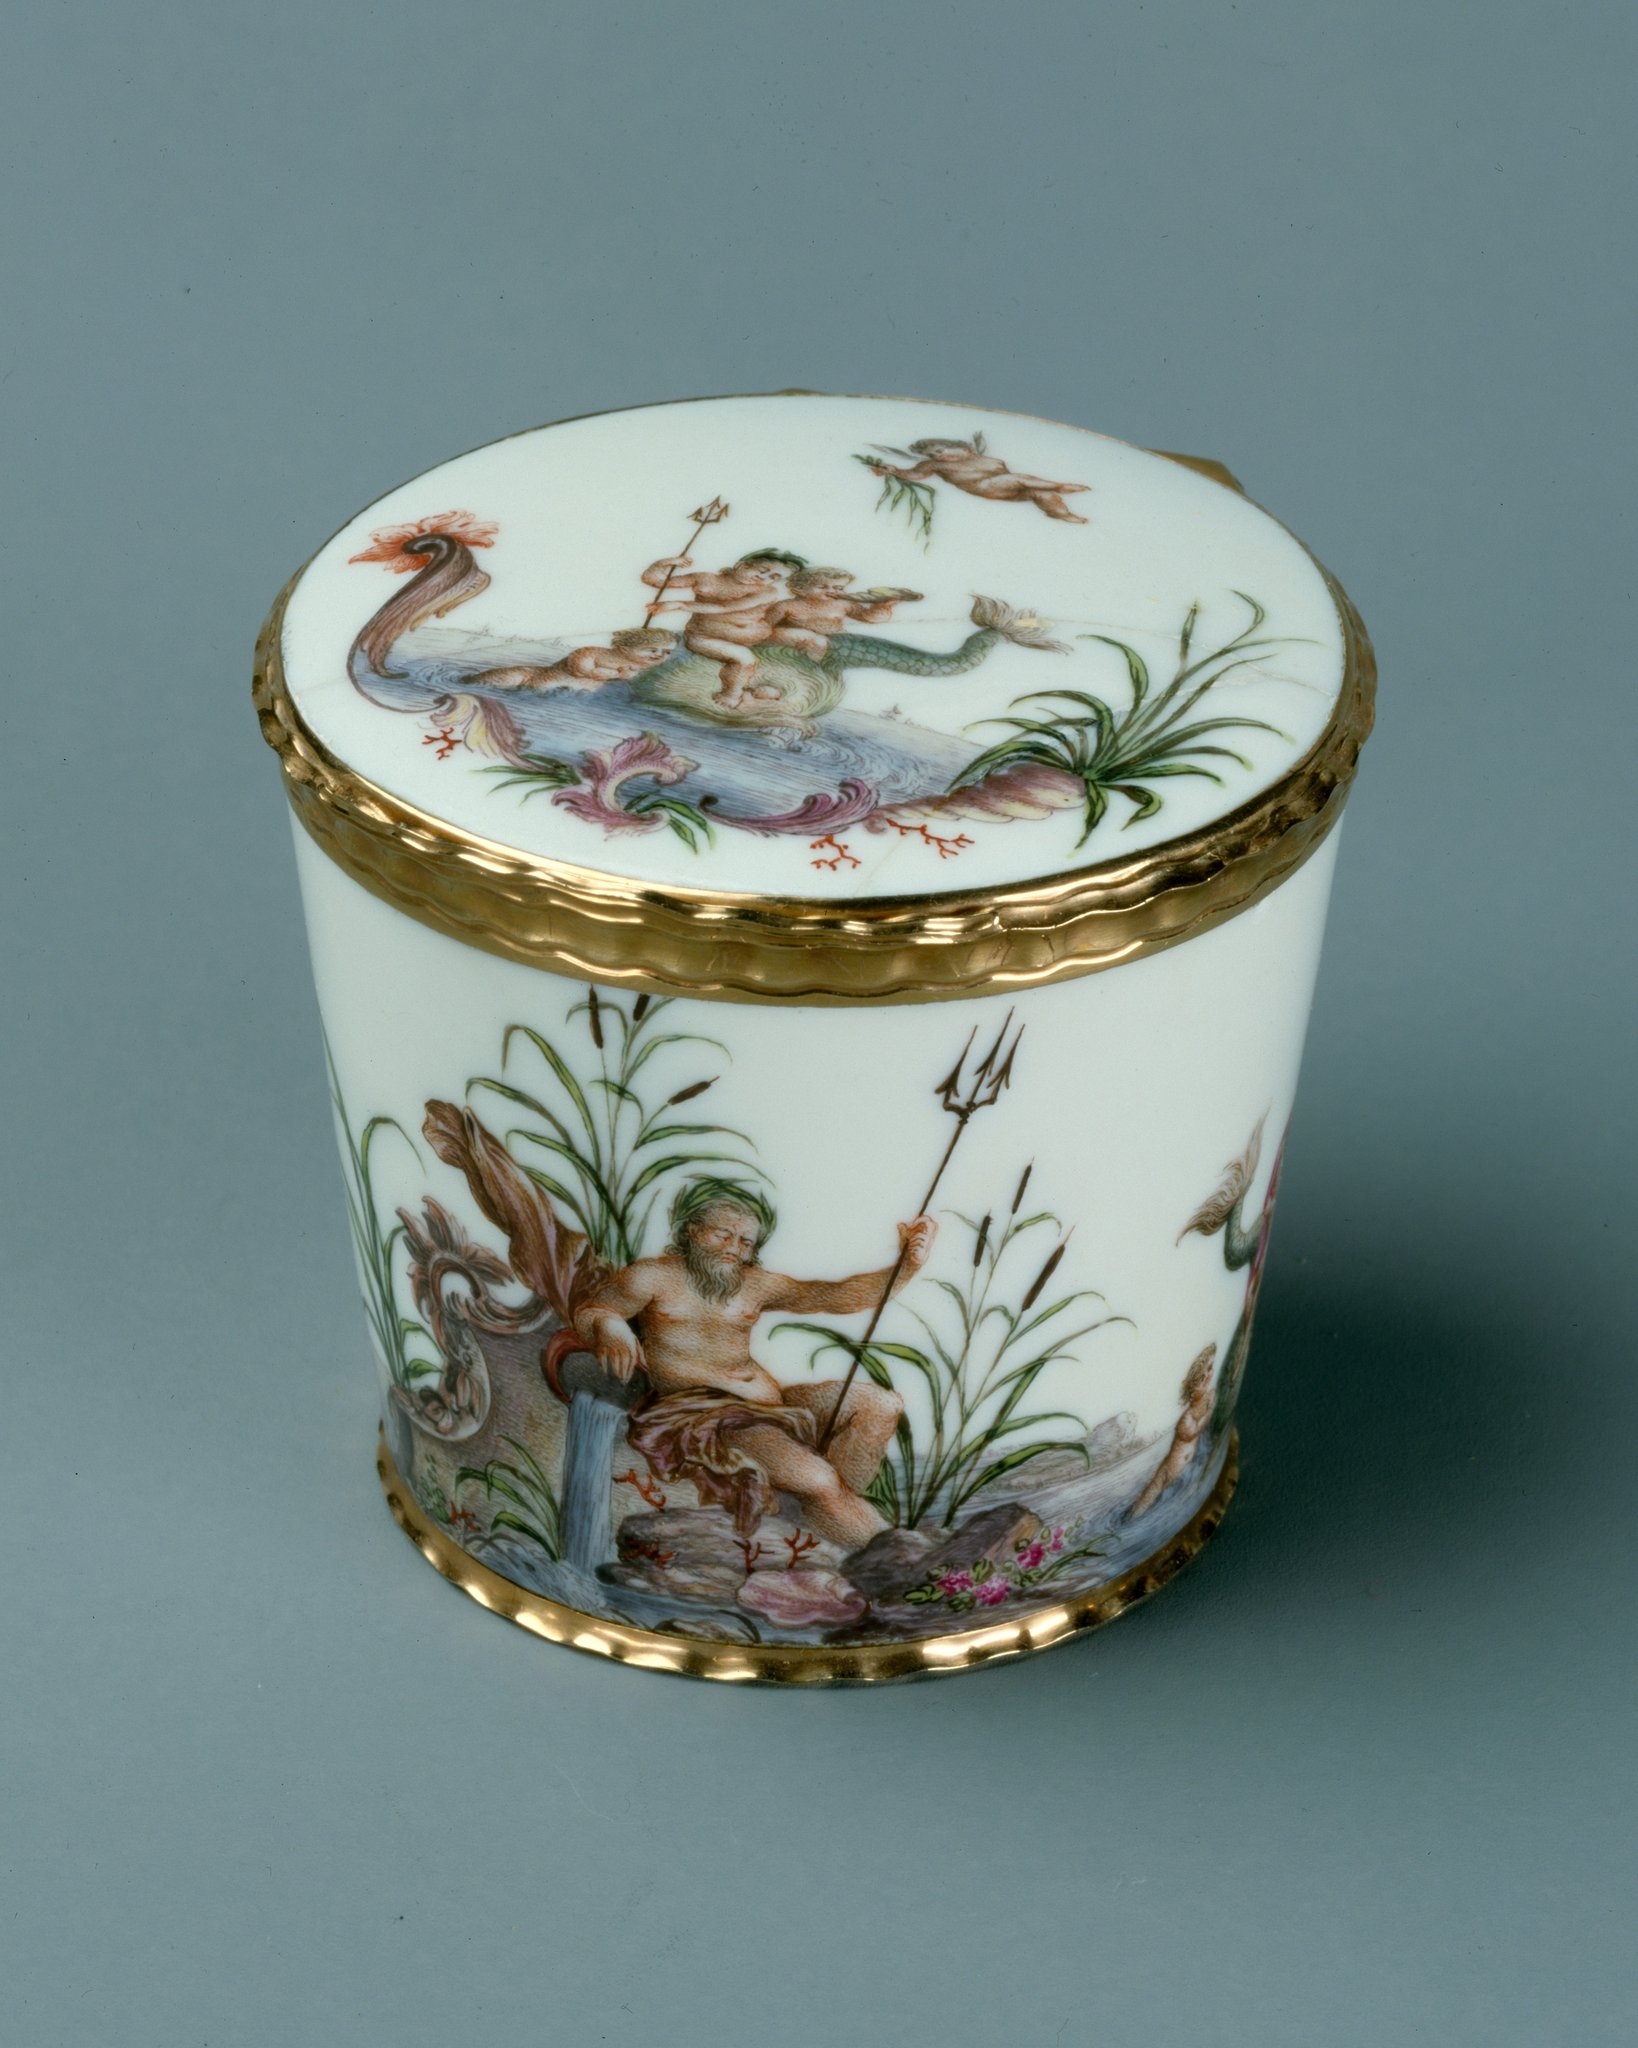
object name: snuffbox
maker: meissen manufactory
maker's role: manufactory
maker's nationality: german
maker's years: 1710-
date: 1744-1750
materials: gold, hard paste porcelain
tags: men,women,putti,bulls,dolphins